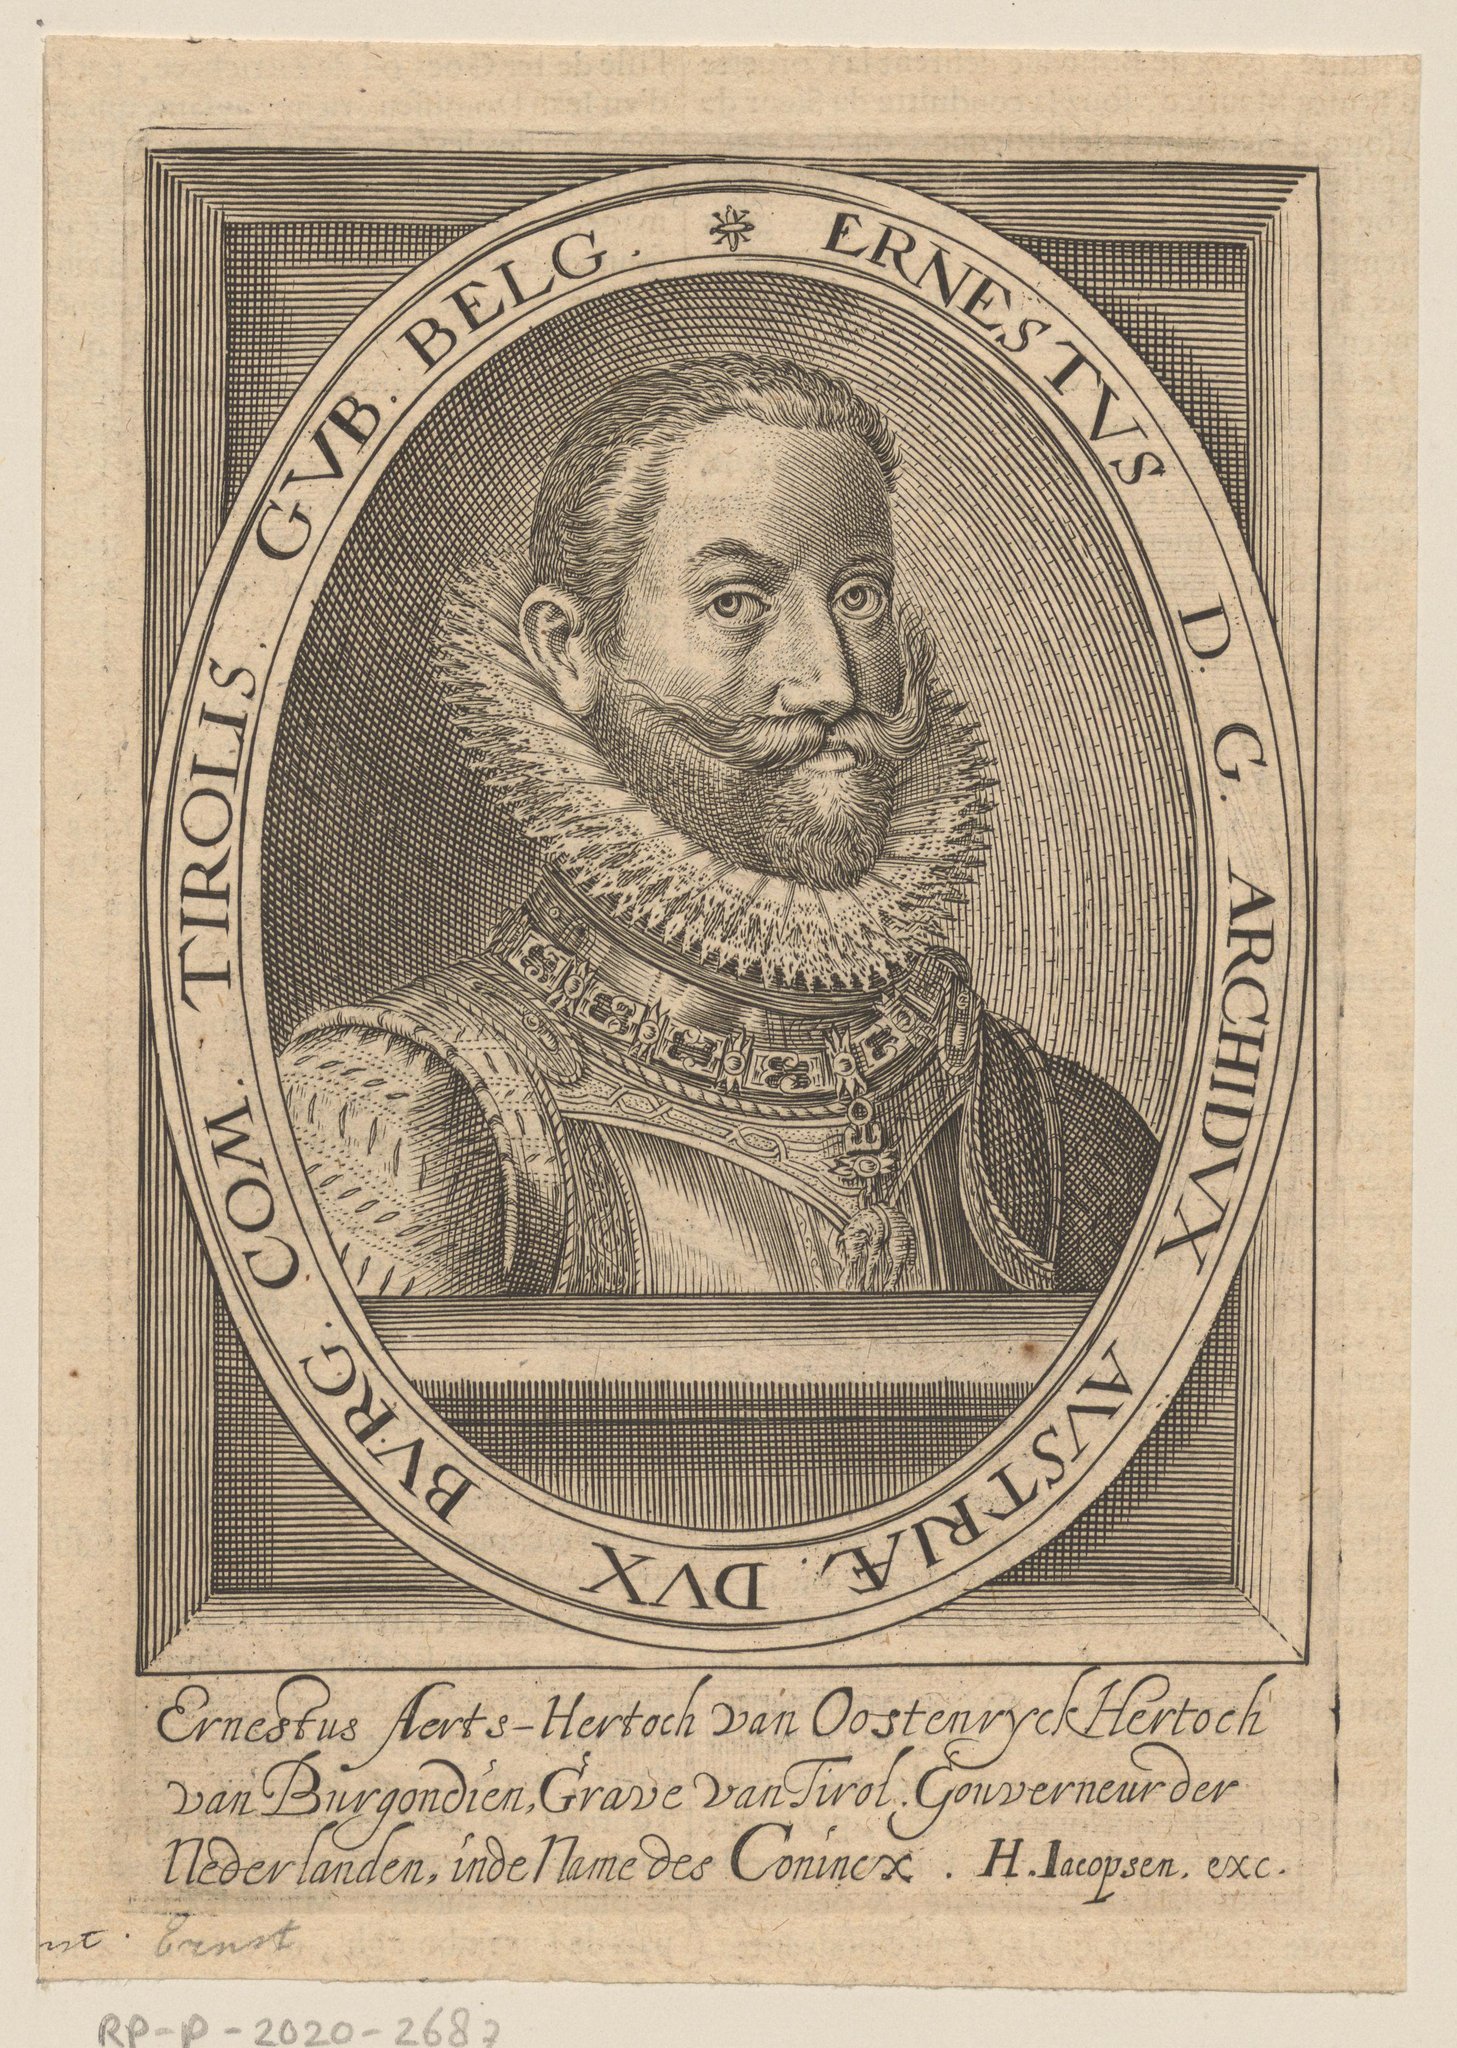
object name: print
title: Portret van Ernst, aartshertog van Oostenrijk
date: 1618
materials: paper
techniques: engraving, letterpress printing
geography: the hague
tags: vienna, brussels, armour, historical persons, knighthood order of the golden fleece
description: Prent uit: Meteren, Emanuel van. L'Histoire des Pays-Bas (...). Den Haag: Hillebrant Jacobsz. van Wouw, 1618. Prent vermoedelijk ook gebruikt in andere edities van Emanuel van Meterens 'Nederlantsche Historien'.